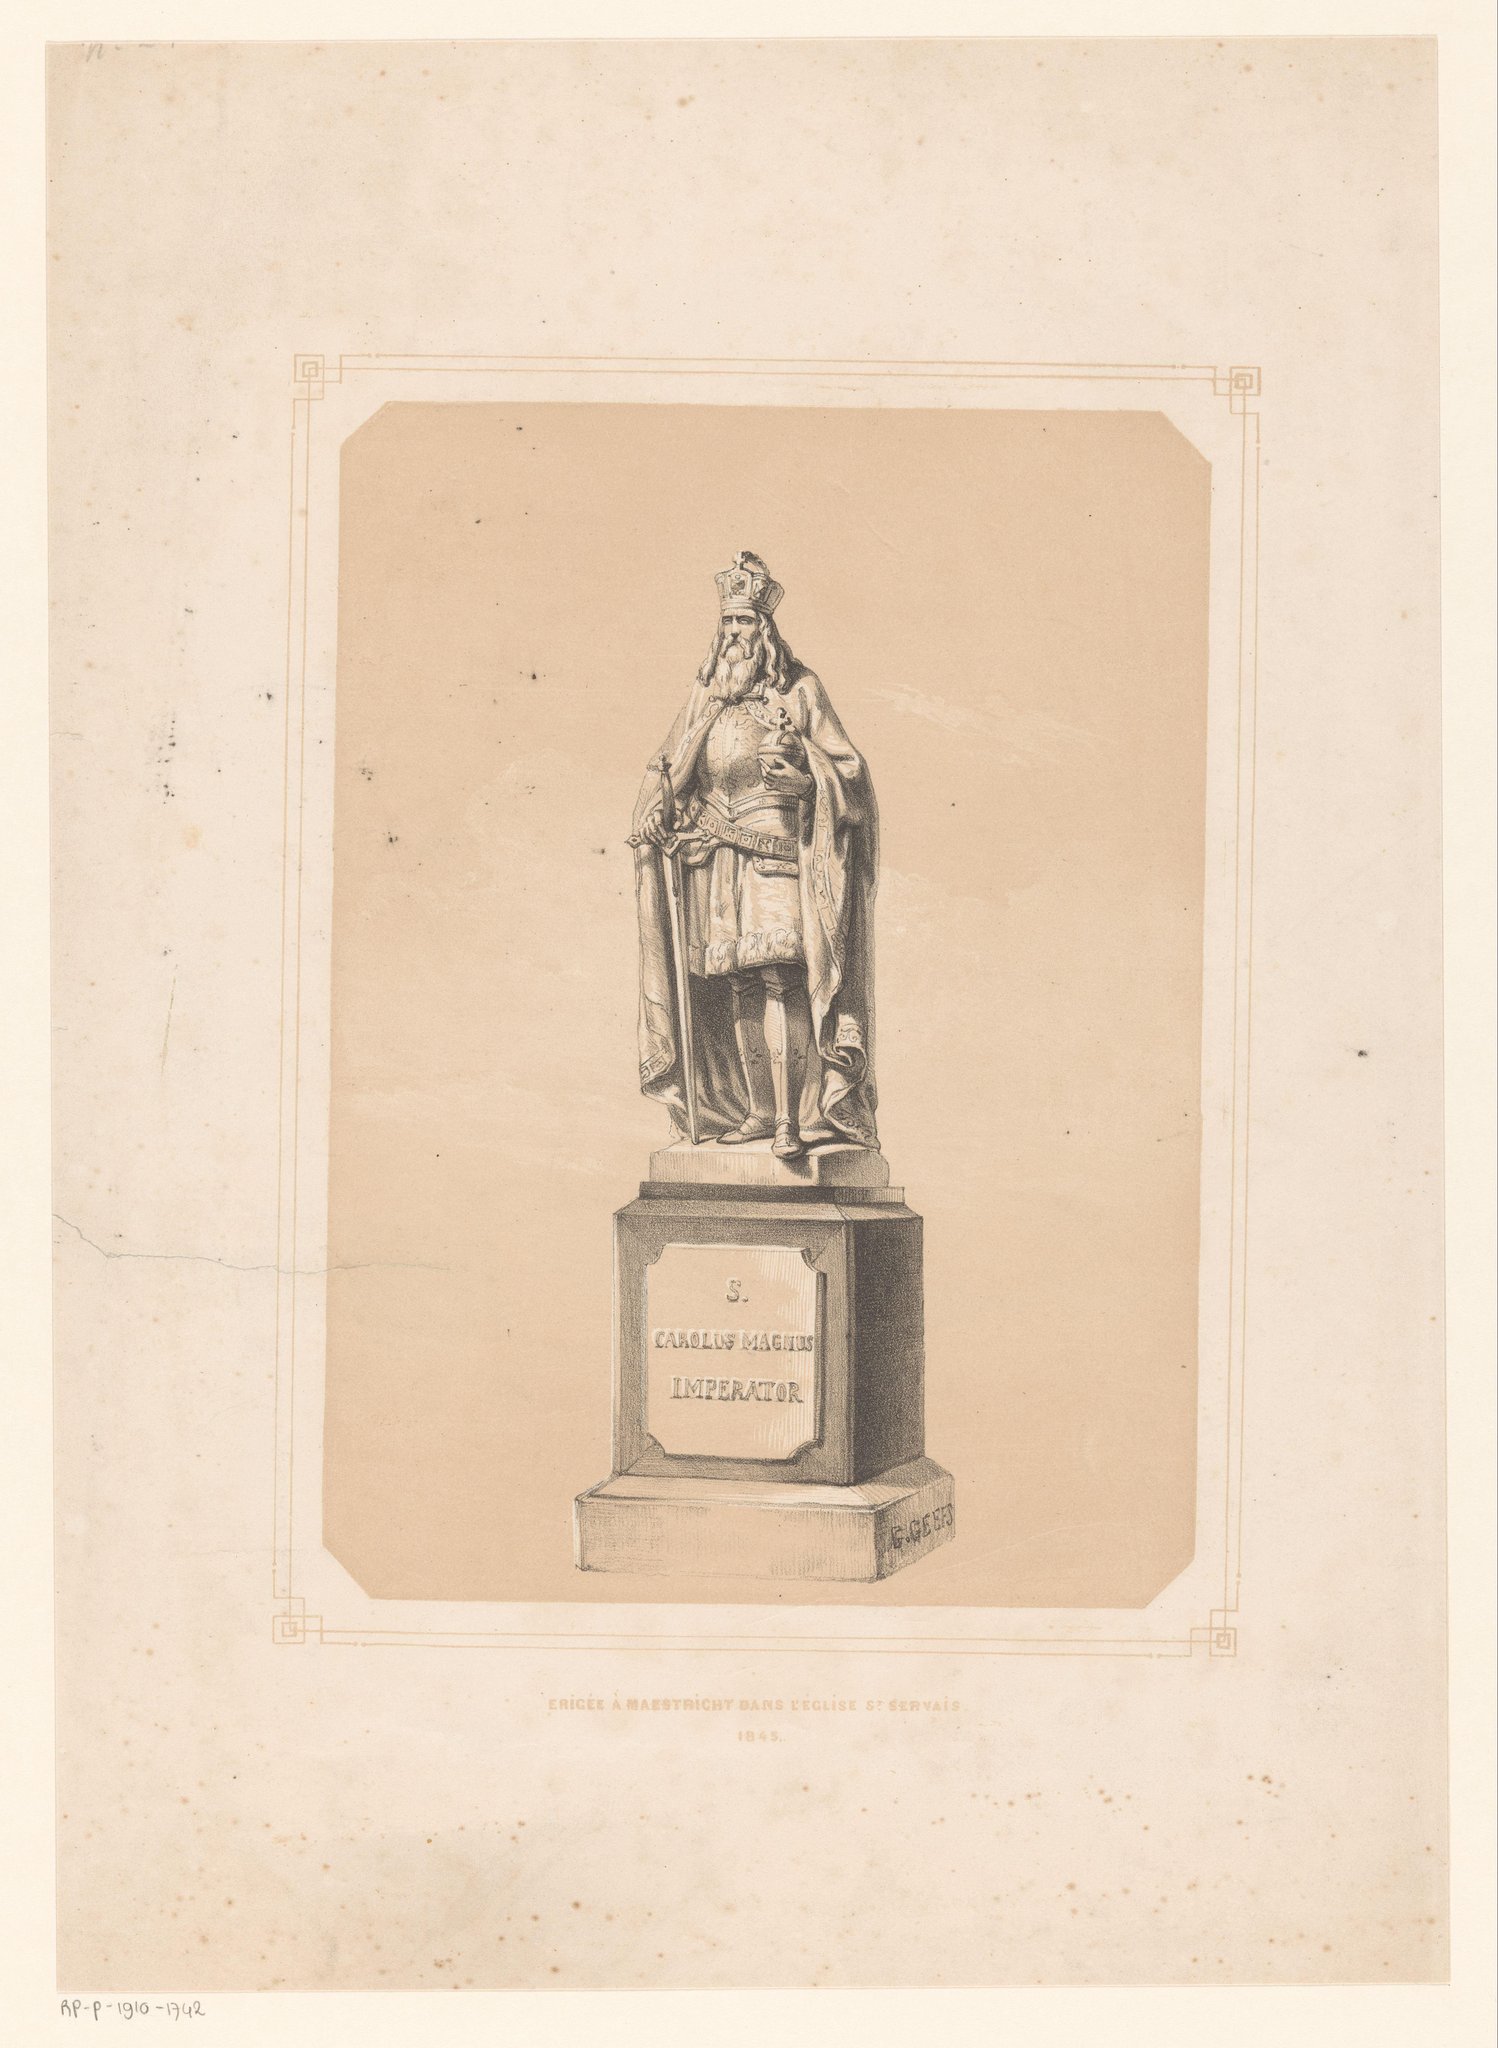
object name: print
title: Standbeeld van Keizer Karel de Grote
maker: Anonymous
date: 1843-1899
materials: paper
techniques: tone lithography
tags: charlemagne (holy roman emperor), monument, statue, insignia and symbols of sovereignty (crown, diadem, sceptre, orb, seal, standard, cloak, pectoral)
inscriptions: collector's mark: Lugt 2228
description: De keizer draagt een kroon. In zijn rechterhand heeft hij een zwaard, in zijn linkerhand een rijksappel. Op de sokkel staat de naam van de beeldhouwer, Guillaume Geefs (1805-1883). Hij maakte het standbeeld in 1843.